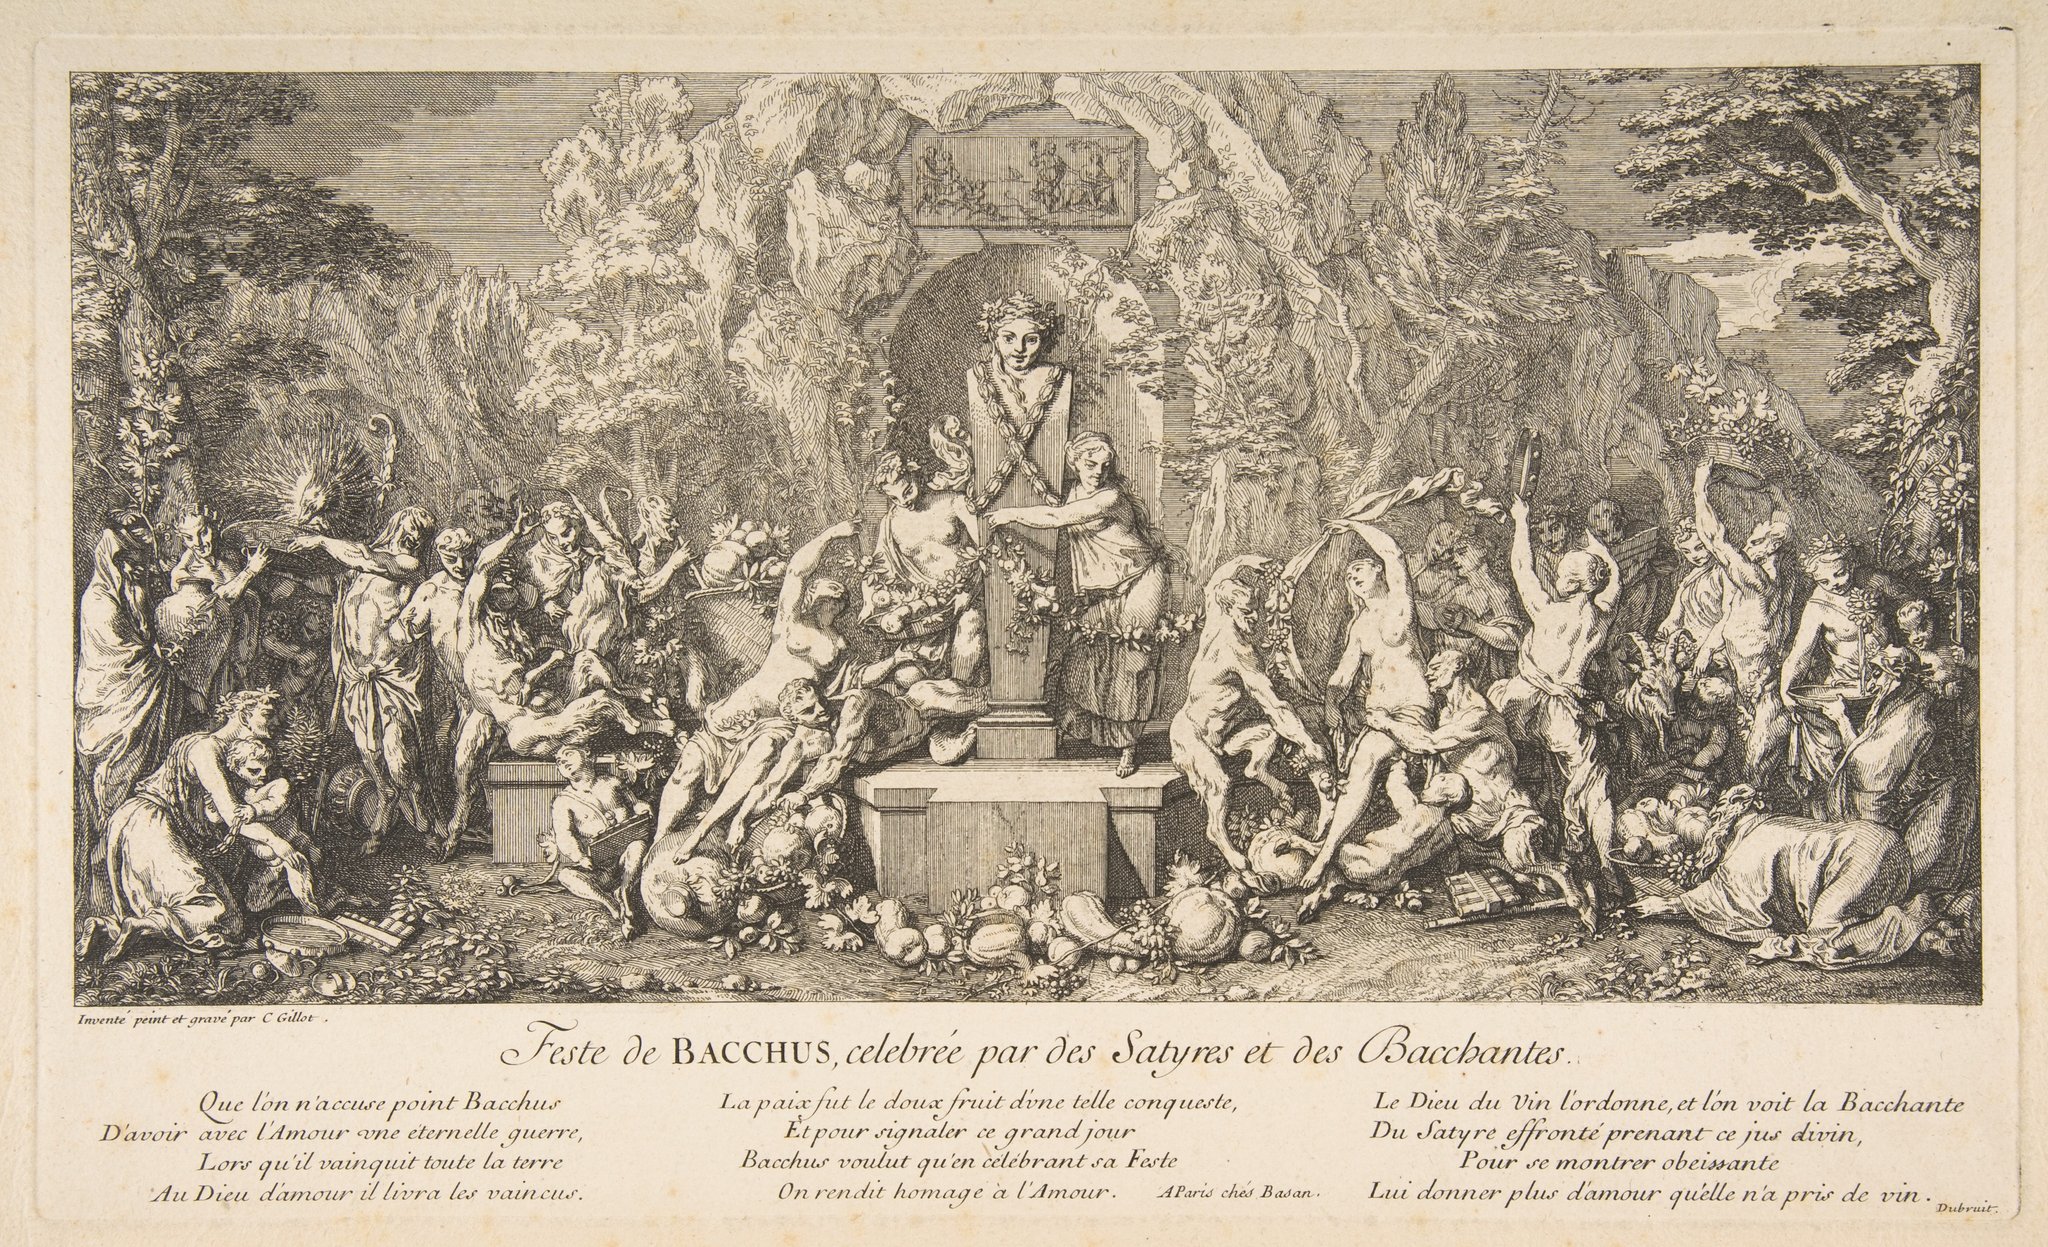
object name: print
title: The Fête of Bacchus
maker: claude gillot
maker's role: artist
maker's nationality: french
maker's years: 1673-1722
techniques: engraving, etching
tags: female nudes,bacchus